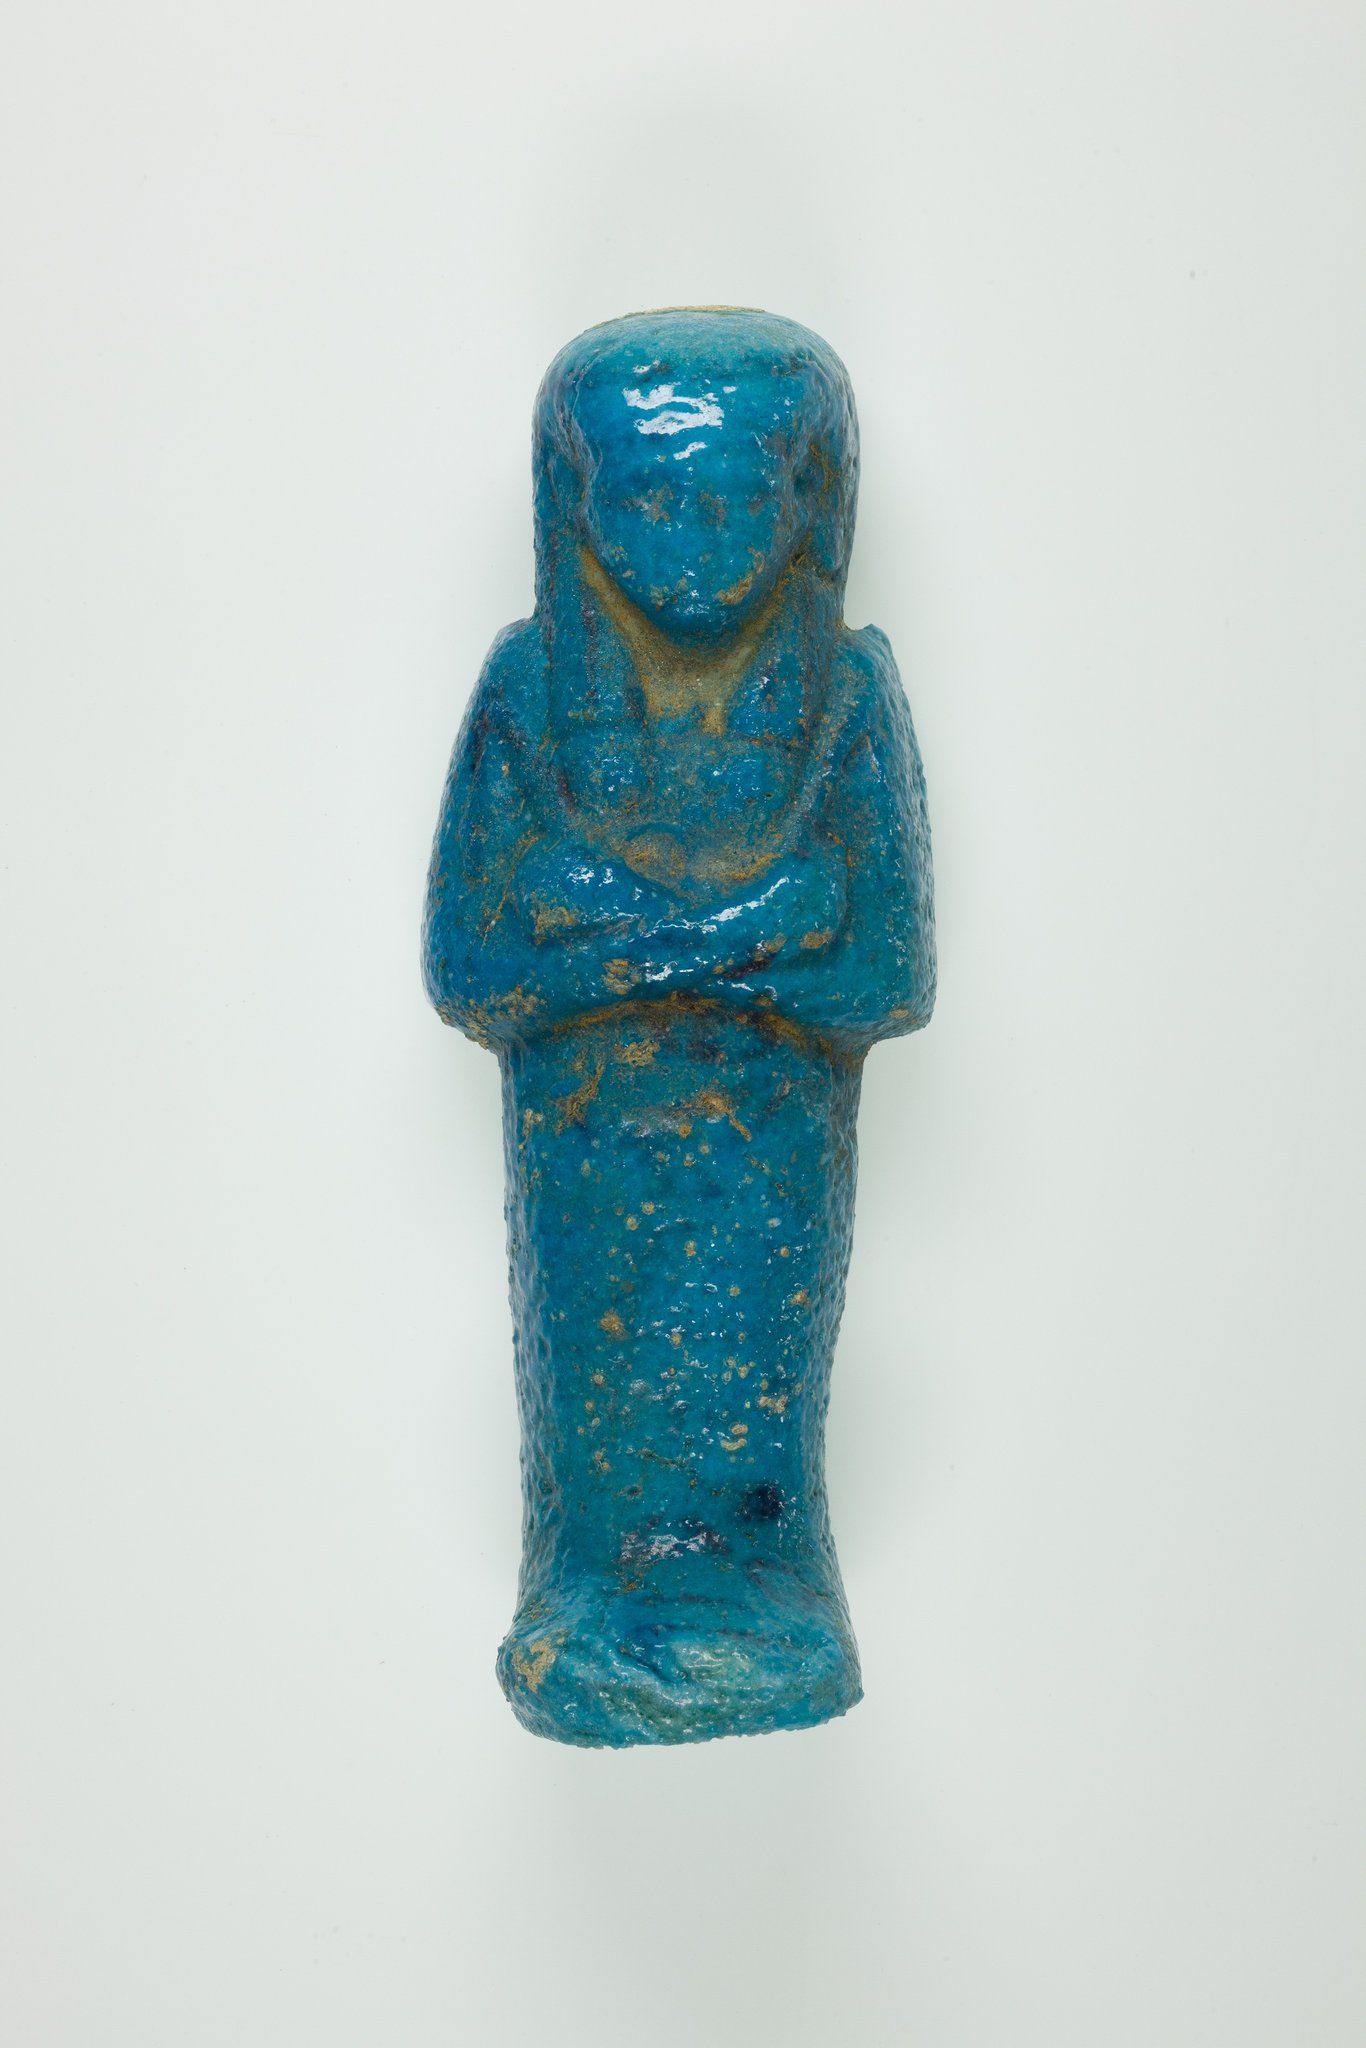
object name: worker shabti, henettawy c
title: Worker Shabti of Henettawy (C), Daughter of Isetemkheb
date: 990-970 BCE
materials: faience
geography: egypt